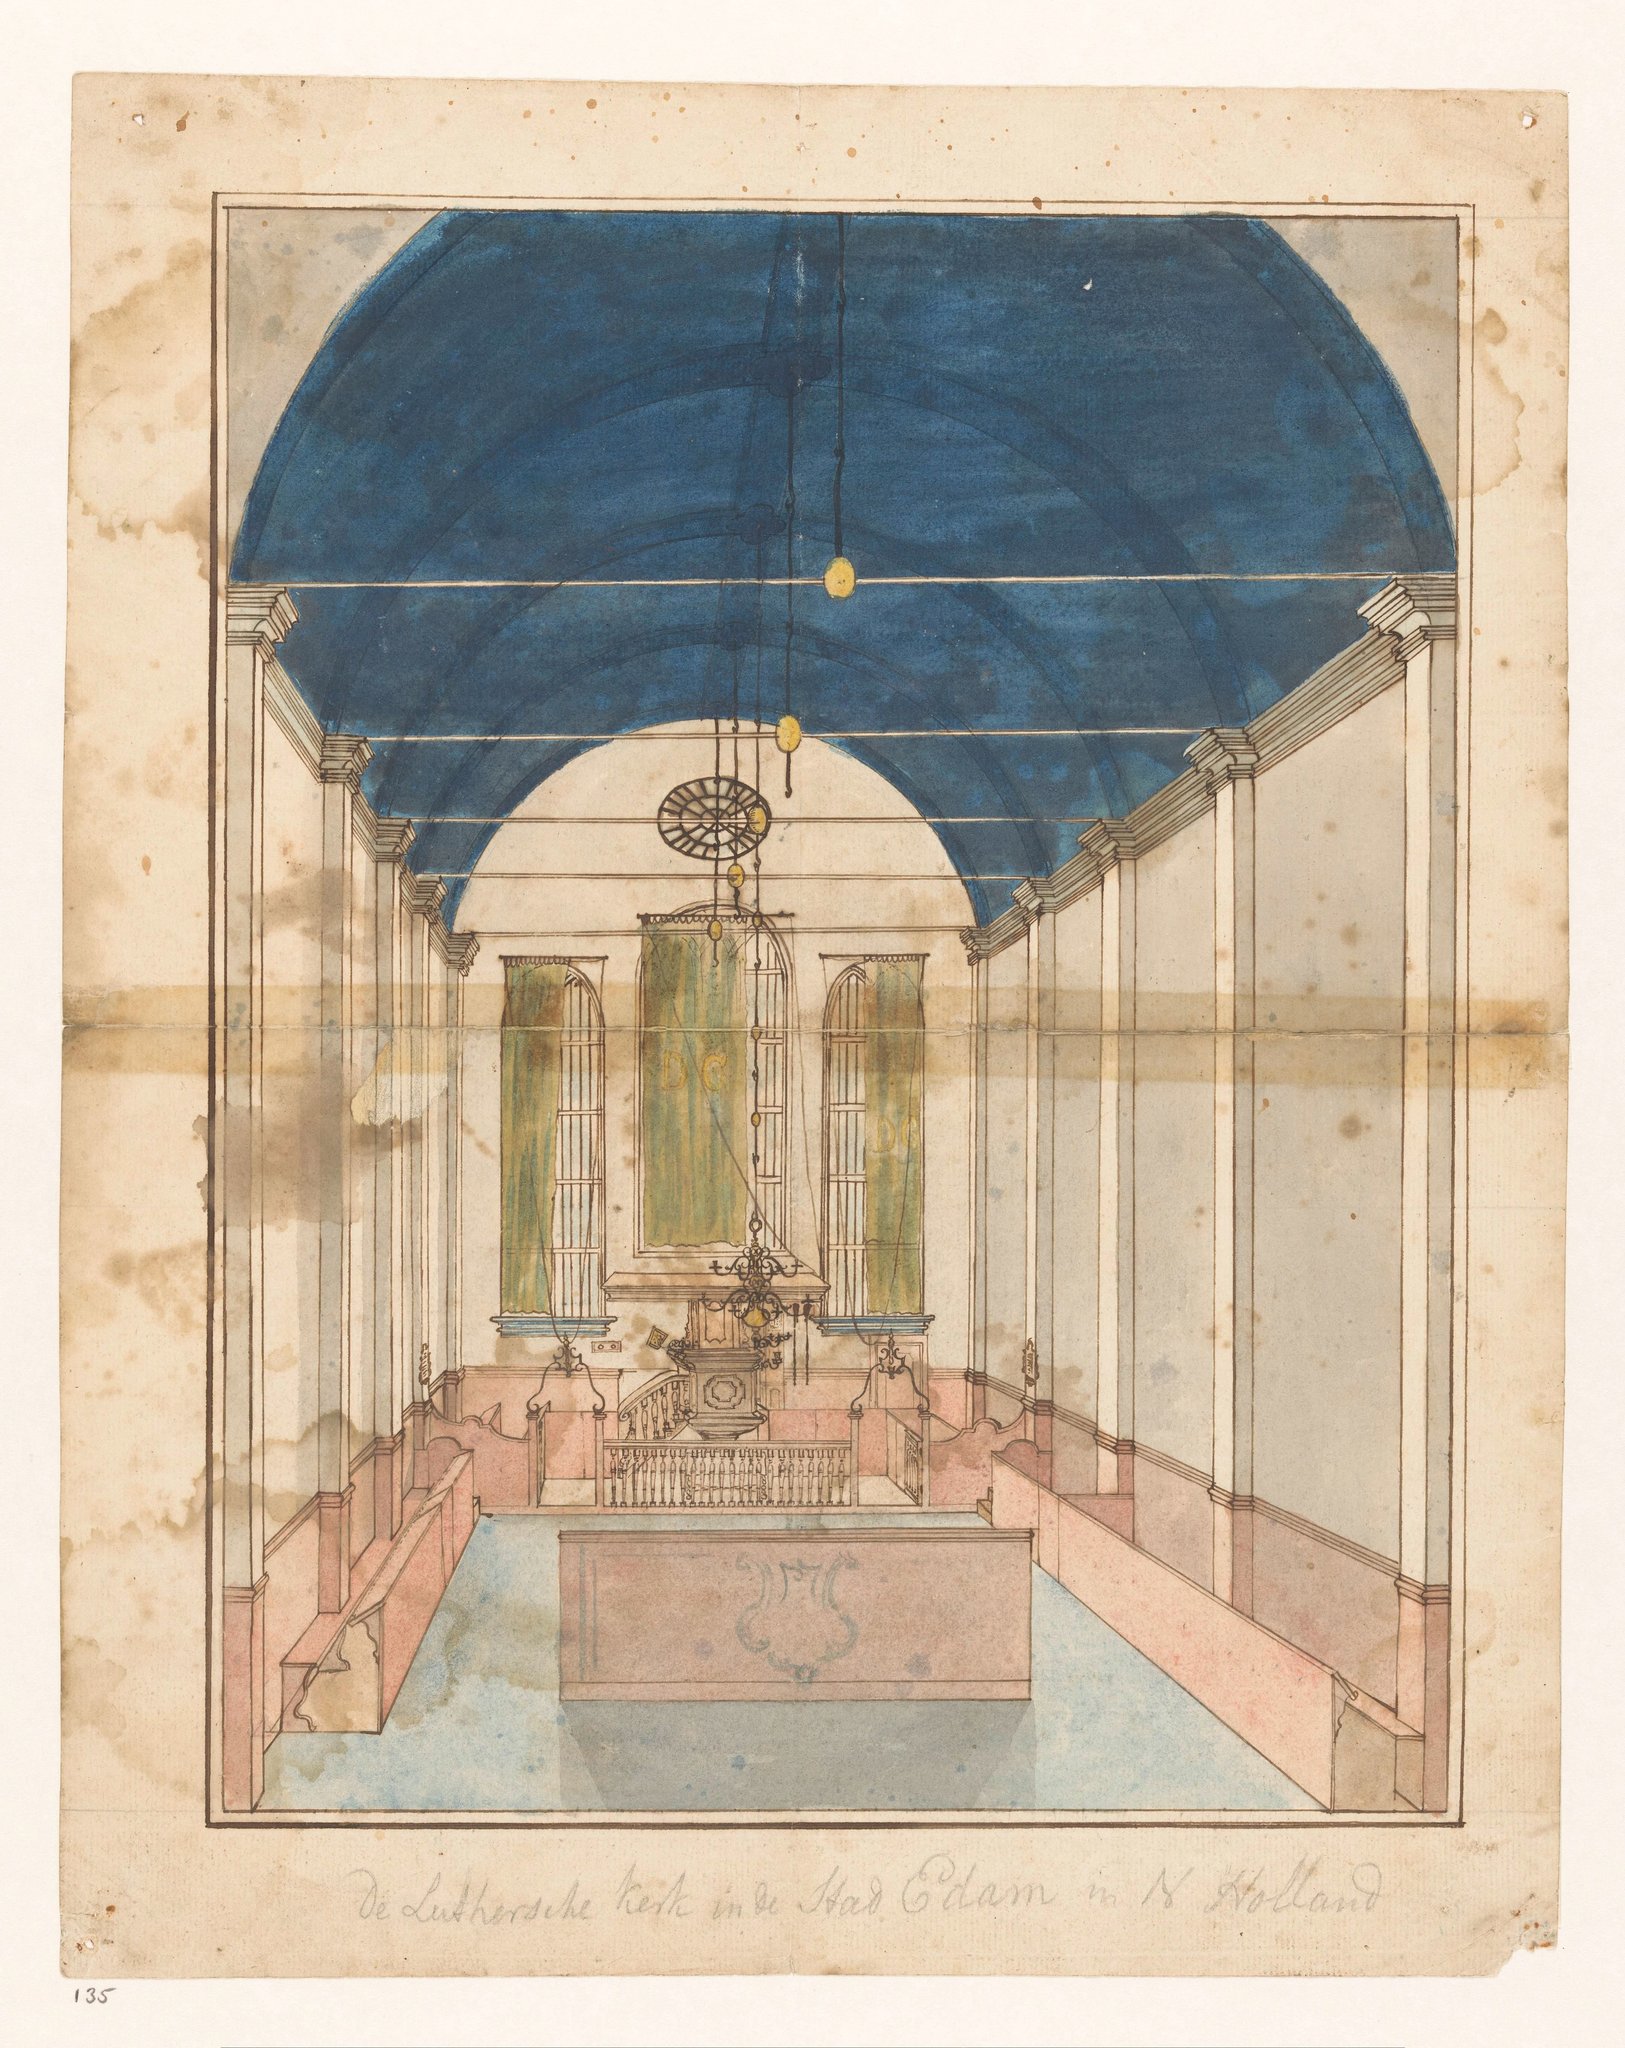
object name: drawing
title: Lutherse kerk in Edam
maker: jan brandes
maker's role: draughtsman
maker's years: 1743-1808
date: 1770-1787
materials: ink, paper, pencil, watercolor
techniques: brush, pen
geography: edam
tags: interior of church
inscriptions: watermark: ‘vrijheyt pro patria eiusgue libertate’, inscription: ‘De Luthersche kerk in de stad Edam in N Holland’